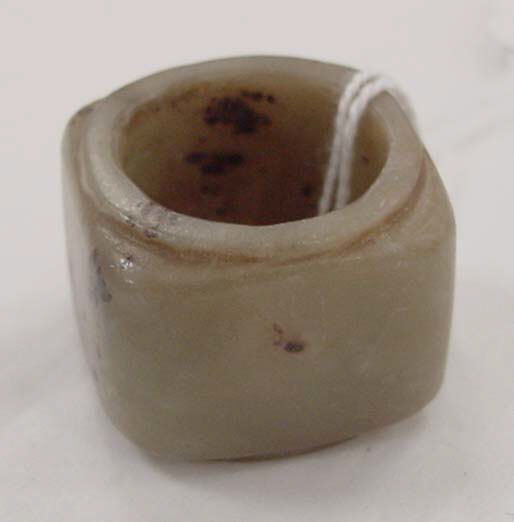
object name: ring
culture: chinese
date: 1801-1900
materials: jade